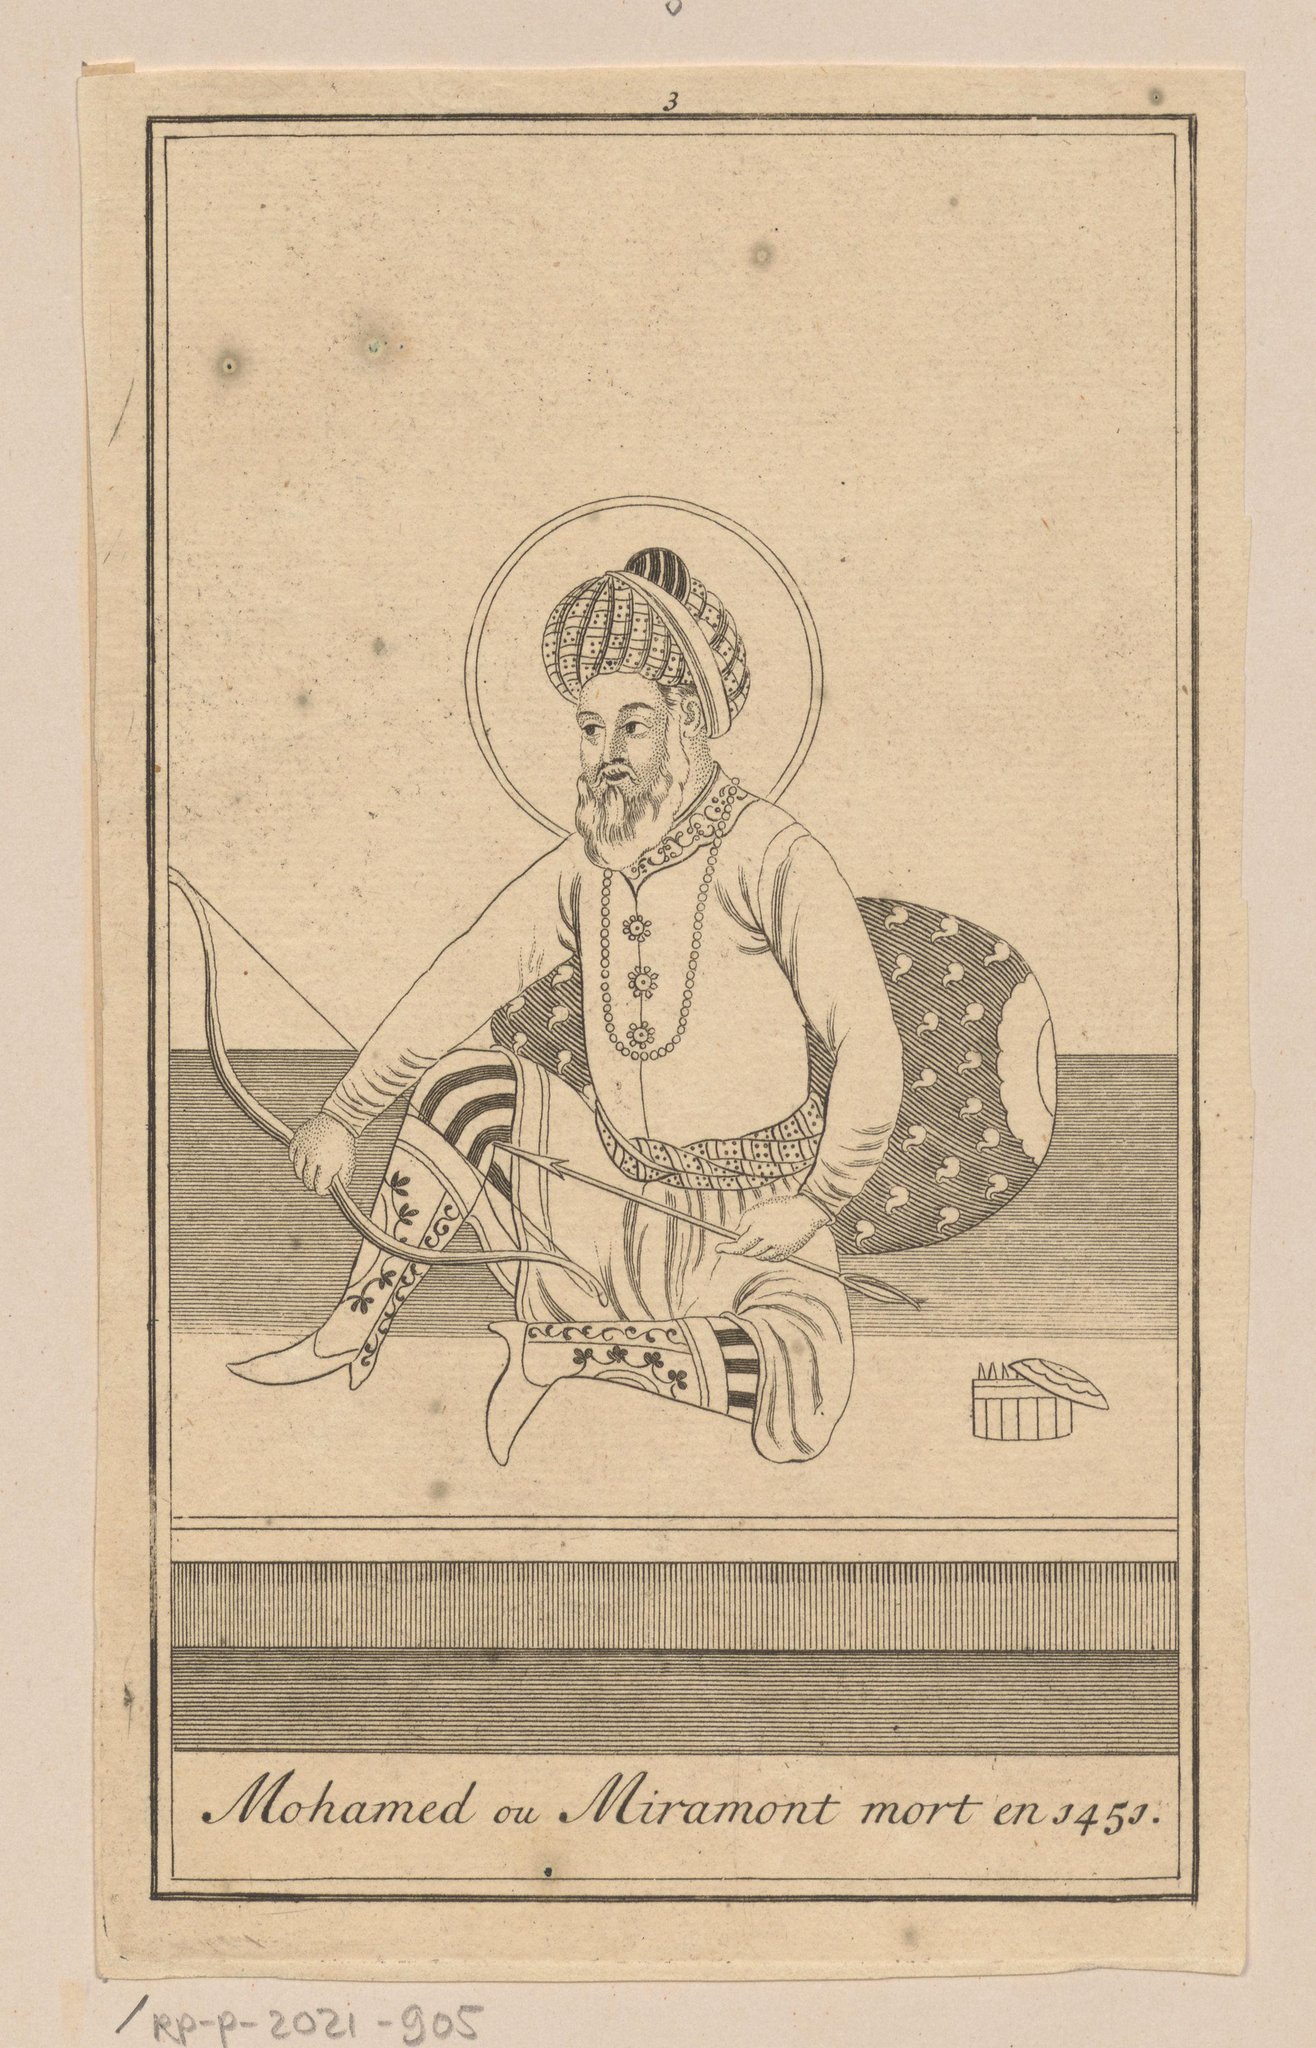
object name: print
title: Portret van meneer Mohamed ou Miramont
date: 1720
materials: paper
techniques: engraving, etching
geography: amsterdam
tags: historical persons, head-gear: turban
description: Prent uit: Chatelain, Henri. Atlas historique, ou nouvelle introduction à l'histoire, à la chronologie et à la géographie ancienne et moderne. Amsterdam: Zacharias (II) Chatelain en François L'Honoré, 1720.